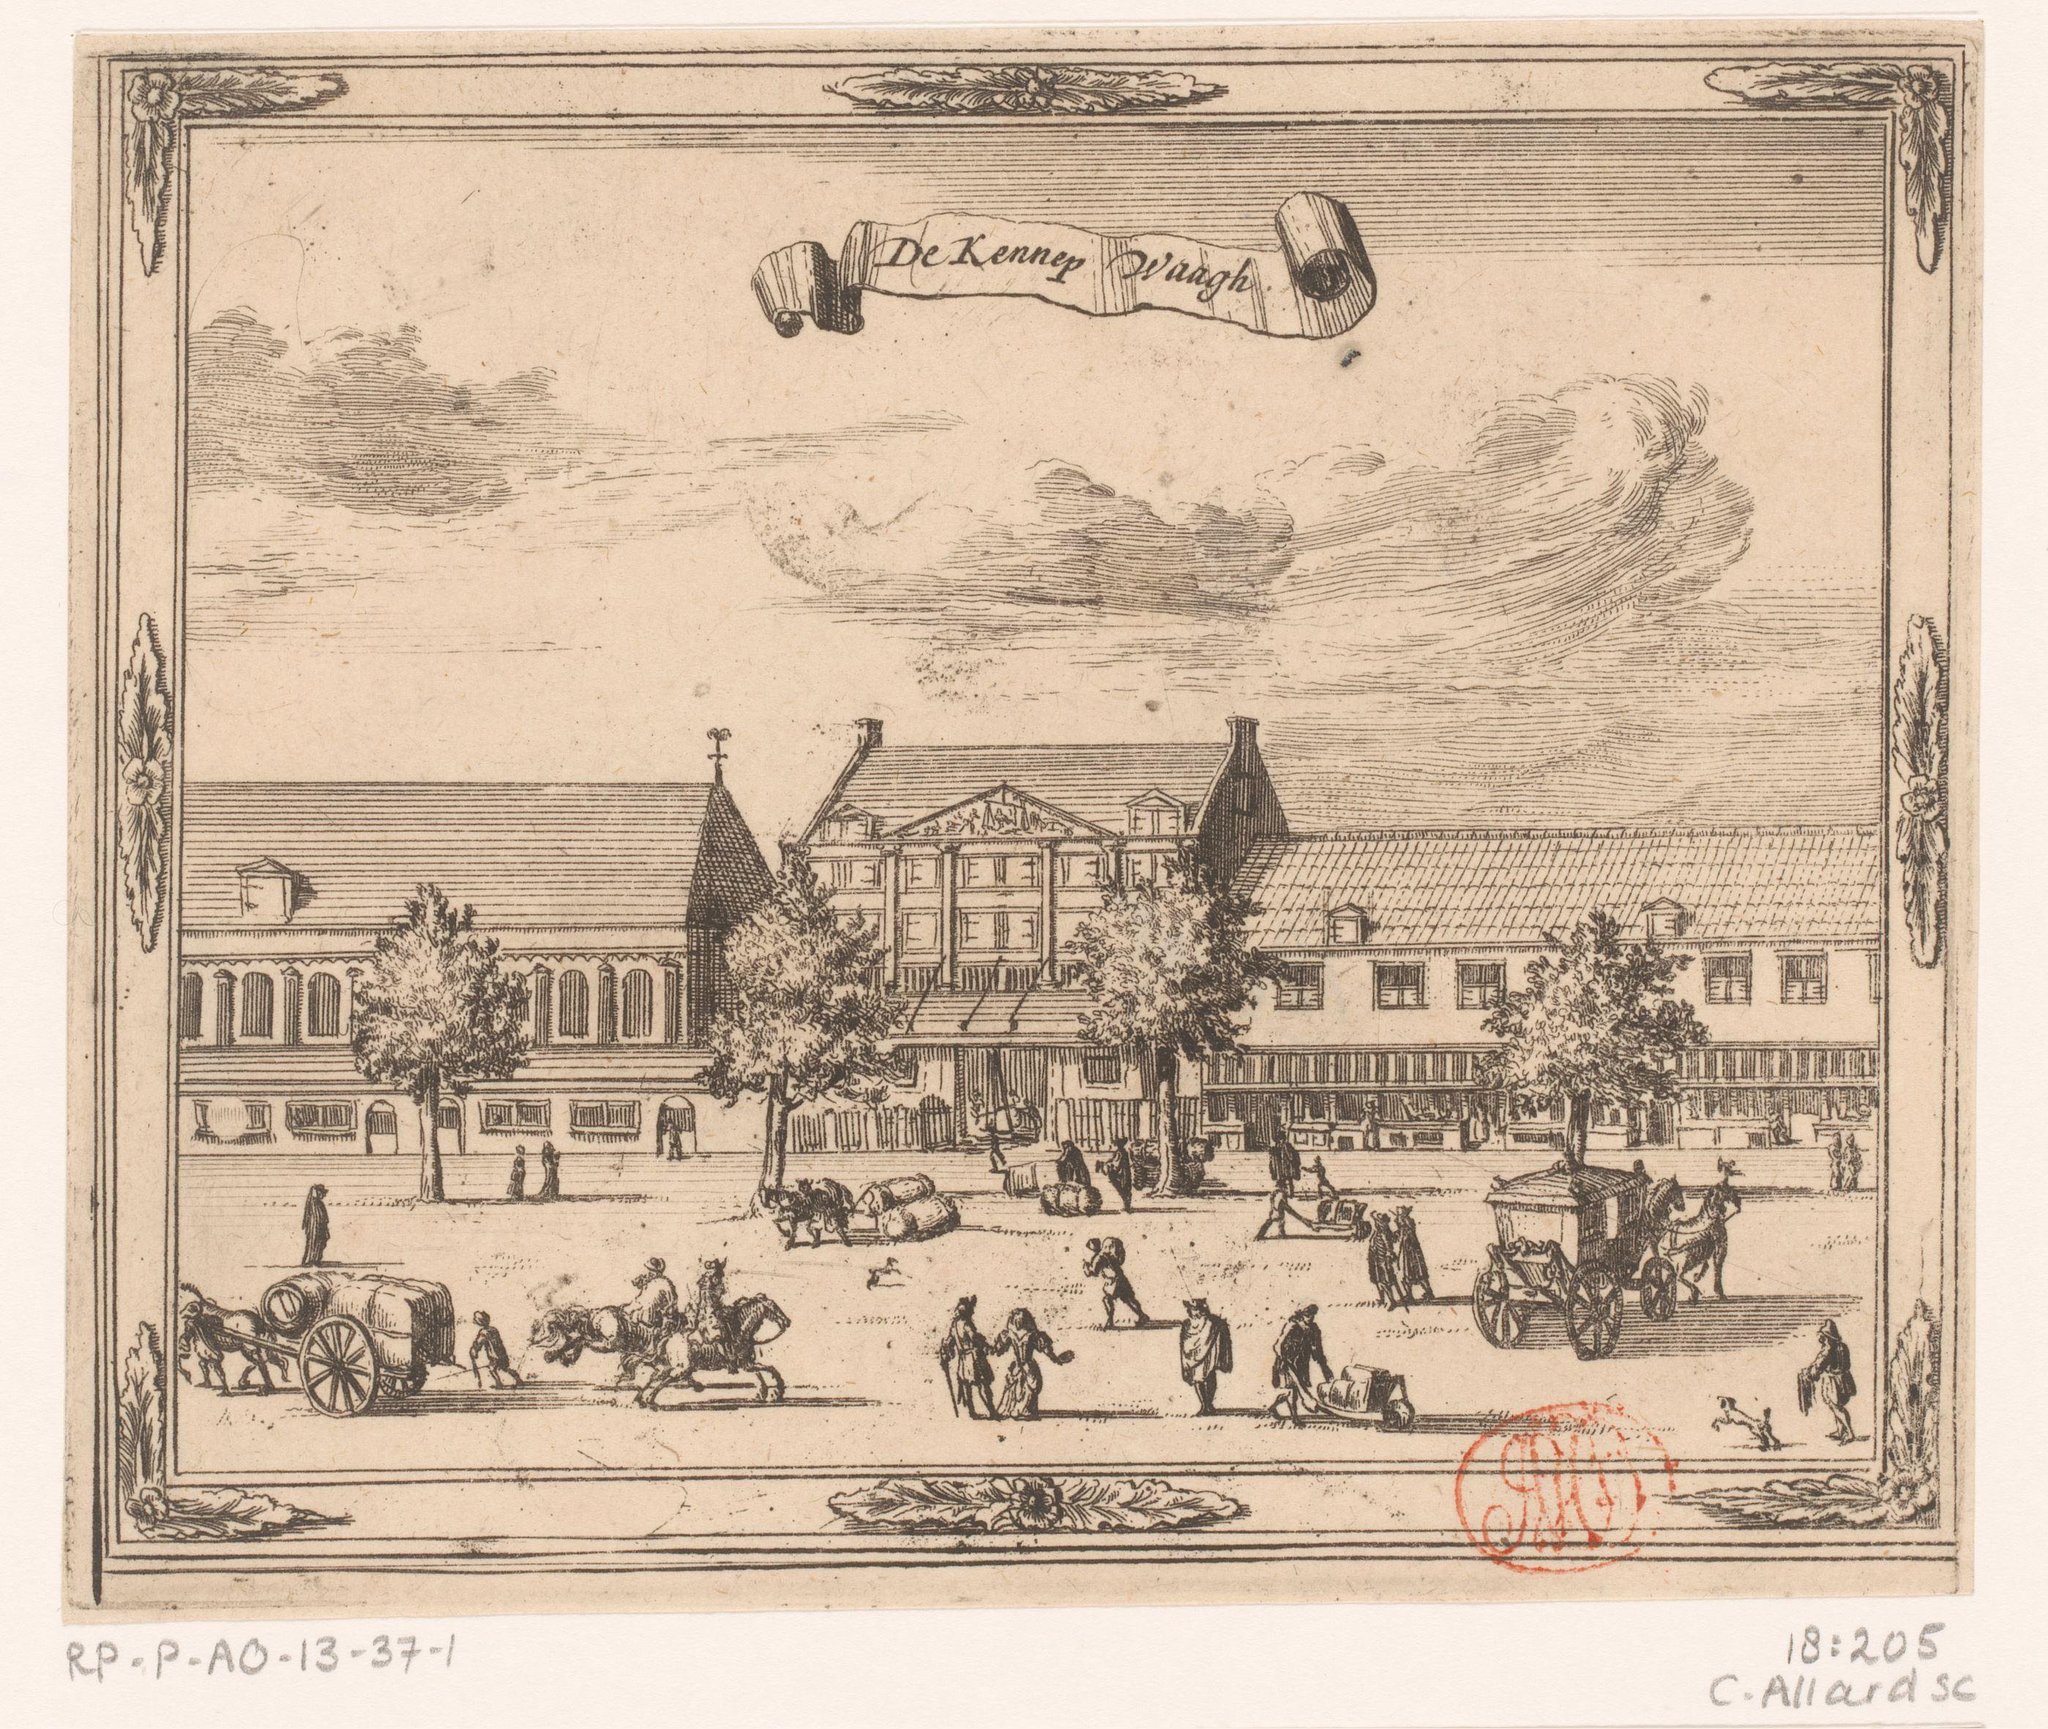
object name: print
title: Les principaux edifices et vues de la ville de Rotterdam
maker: jacobus harrewijn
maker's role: print maker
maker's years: 1660-1740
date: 1715-1730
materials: paper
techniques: etching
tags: church (exterior), weigh-house, market-hall, street (+ city(-scape) with figures, staffage), rotterdam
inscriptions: collector's mark: Lugt 2228, collector's mark: Lugt 195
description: Prent vermoedelijk eerst met dertien andere stadsgezichten uitgegeven als onderdeel van de sierrand van – in ieder geval de derde staat en mogelijk ook de tweede van – de plattegrond 'Tabula Roterodami Novissima' (zie RP-P-AO-13-11). Later nog een keer als onderdeel van een prentserie uitgegeven: Les principaux edifices et vues de la ville de Rotterdam. Le tout fidèlement dessiné sur les lieux. Leiden: Pieter van der Aa, s.a. [adres 'dans l'Academie', dus 1715-1730]. De platen zijn voor zover na te gaan ongewijzigd gebleven.